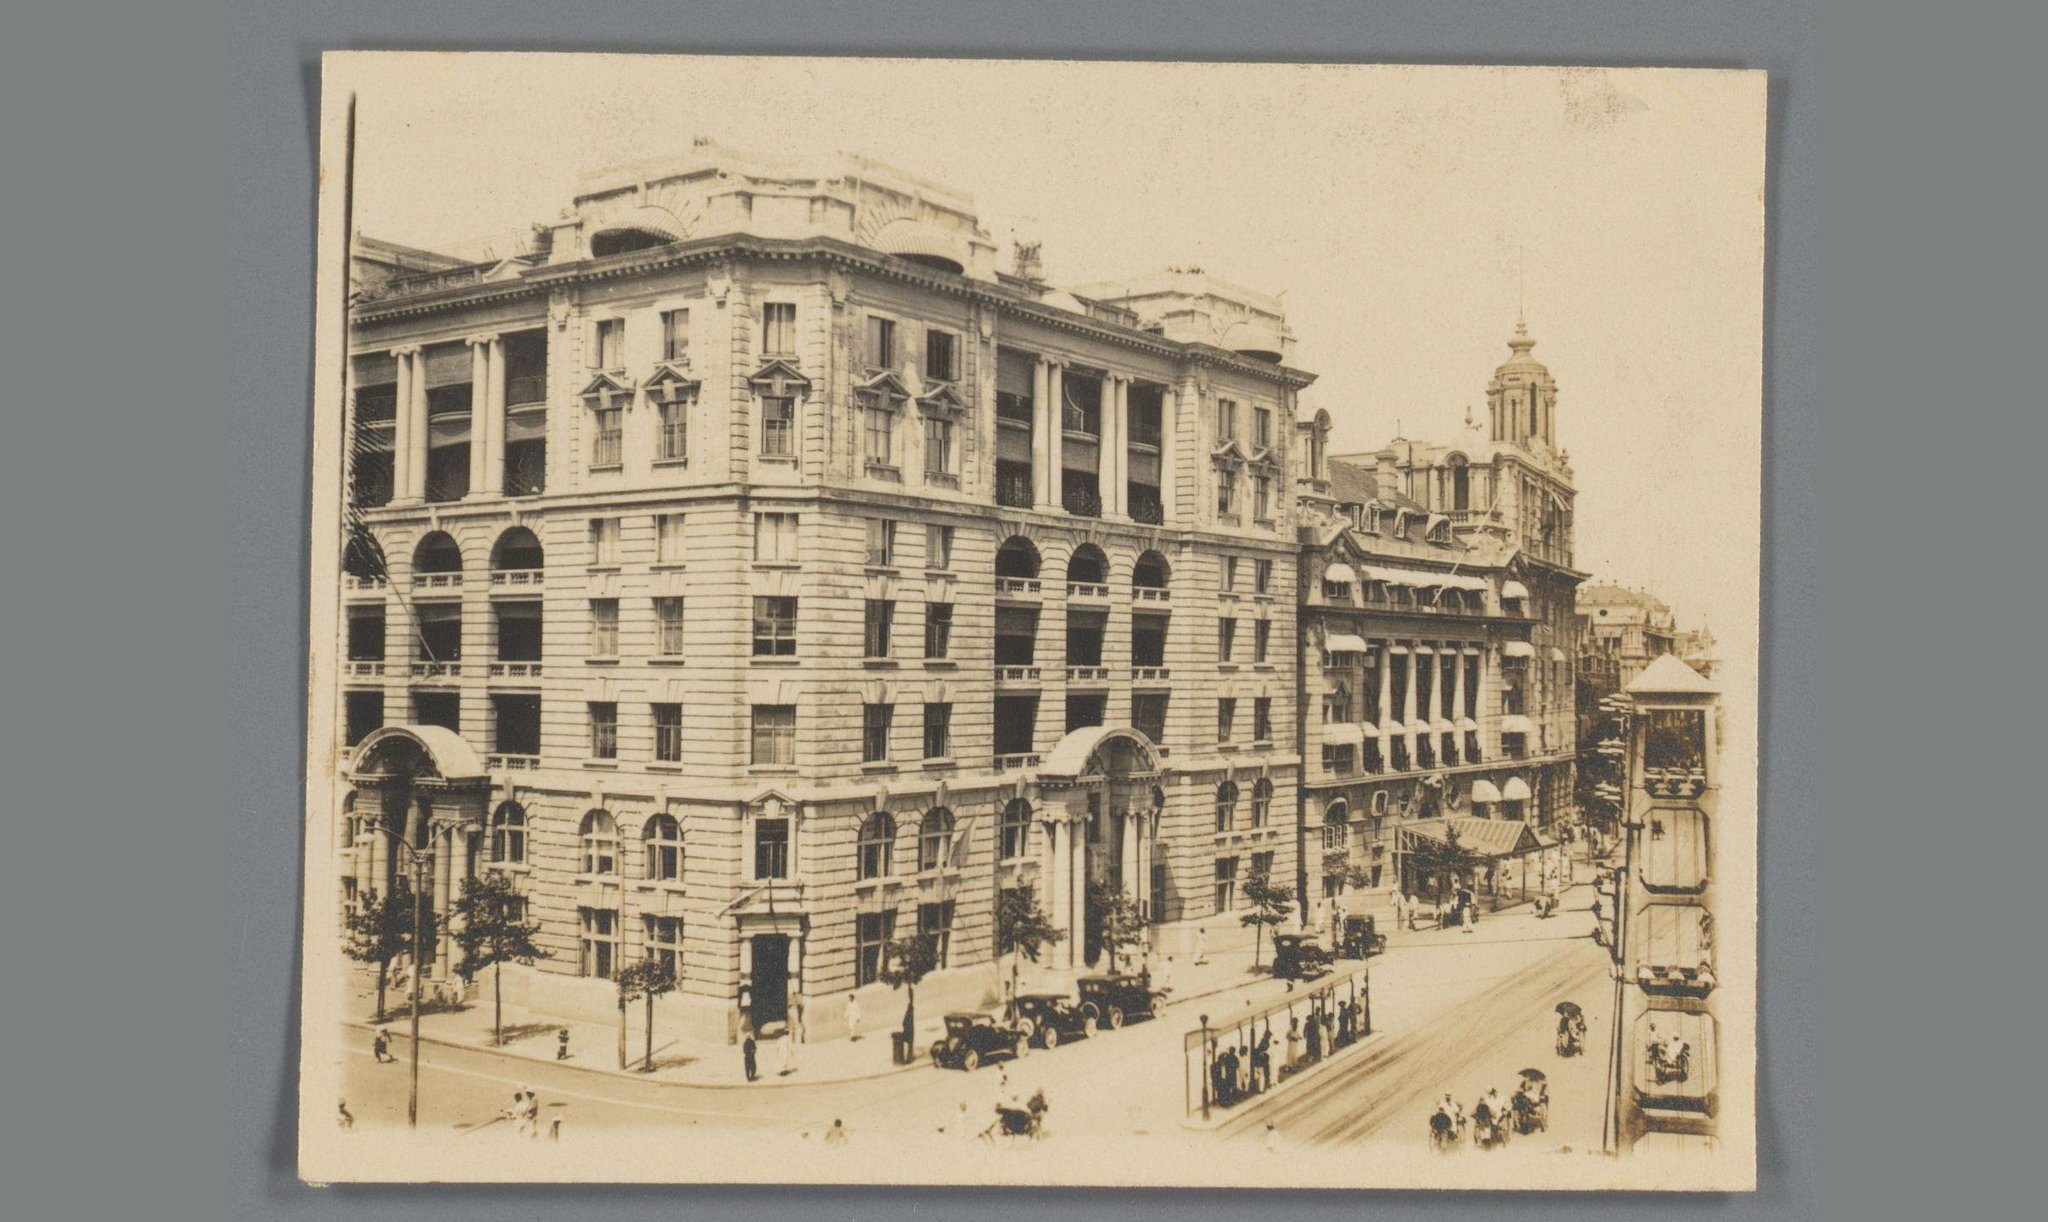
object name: photograph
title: Gezicht op McBain Building aan de Bund, Shanghai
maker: Anonymous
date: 1916-1930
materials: paper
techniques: gelatin silver print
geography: shanghai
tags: avenue, boulevard, promenade, esplanade, edifice, e.g.: public building, department store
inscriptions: stamp: ‘Copyright Photograph by Mactavish & Co., Ltd./ Shanghai.’